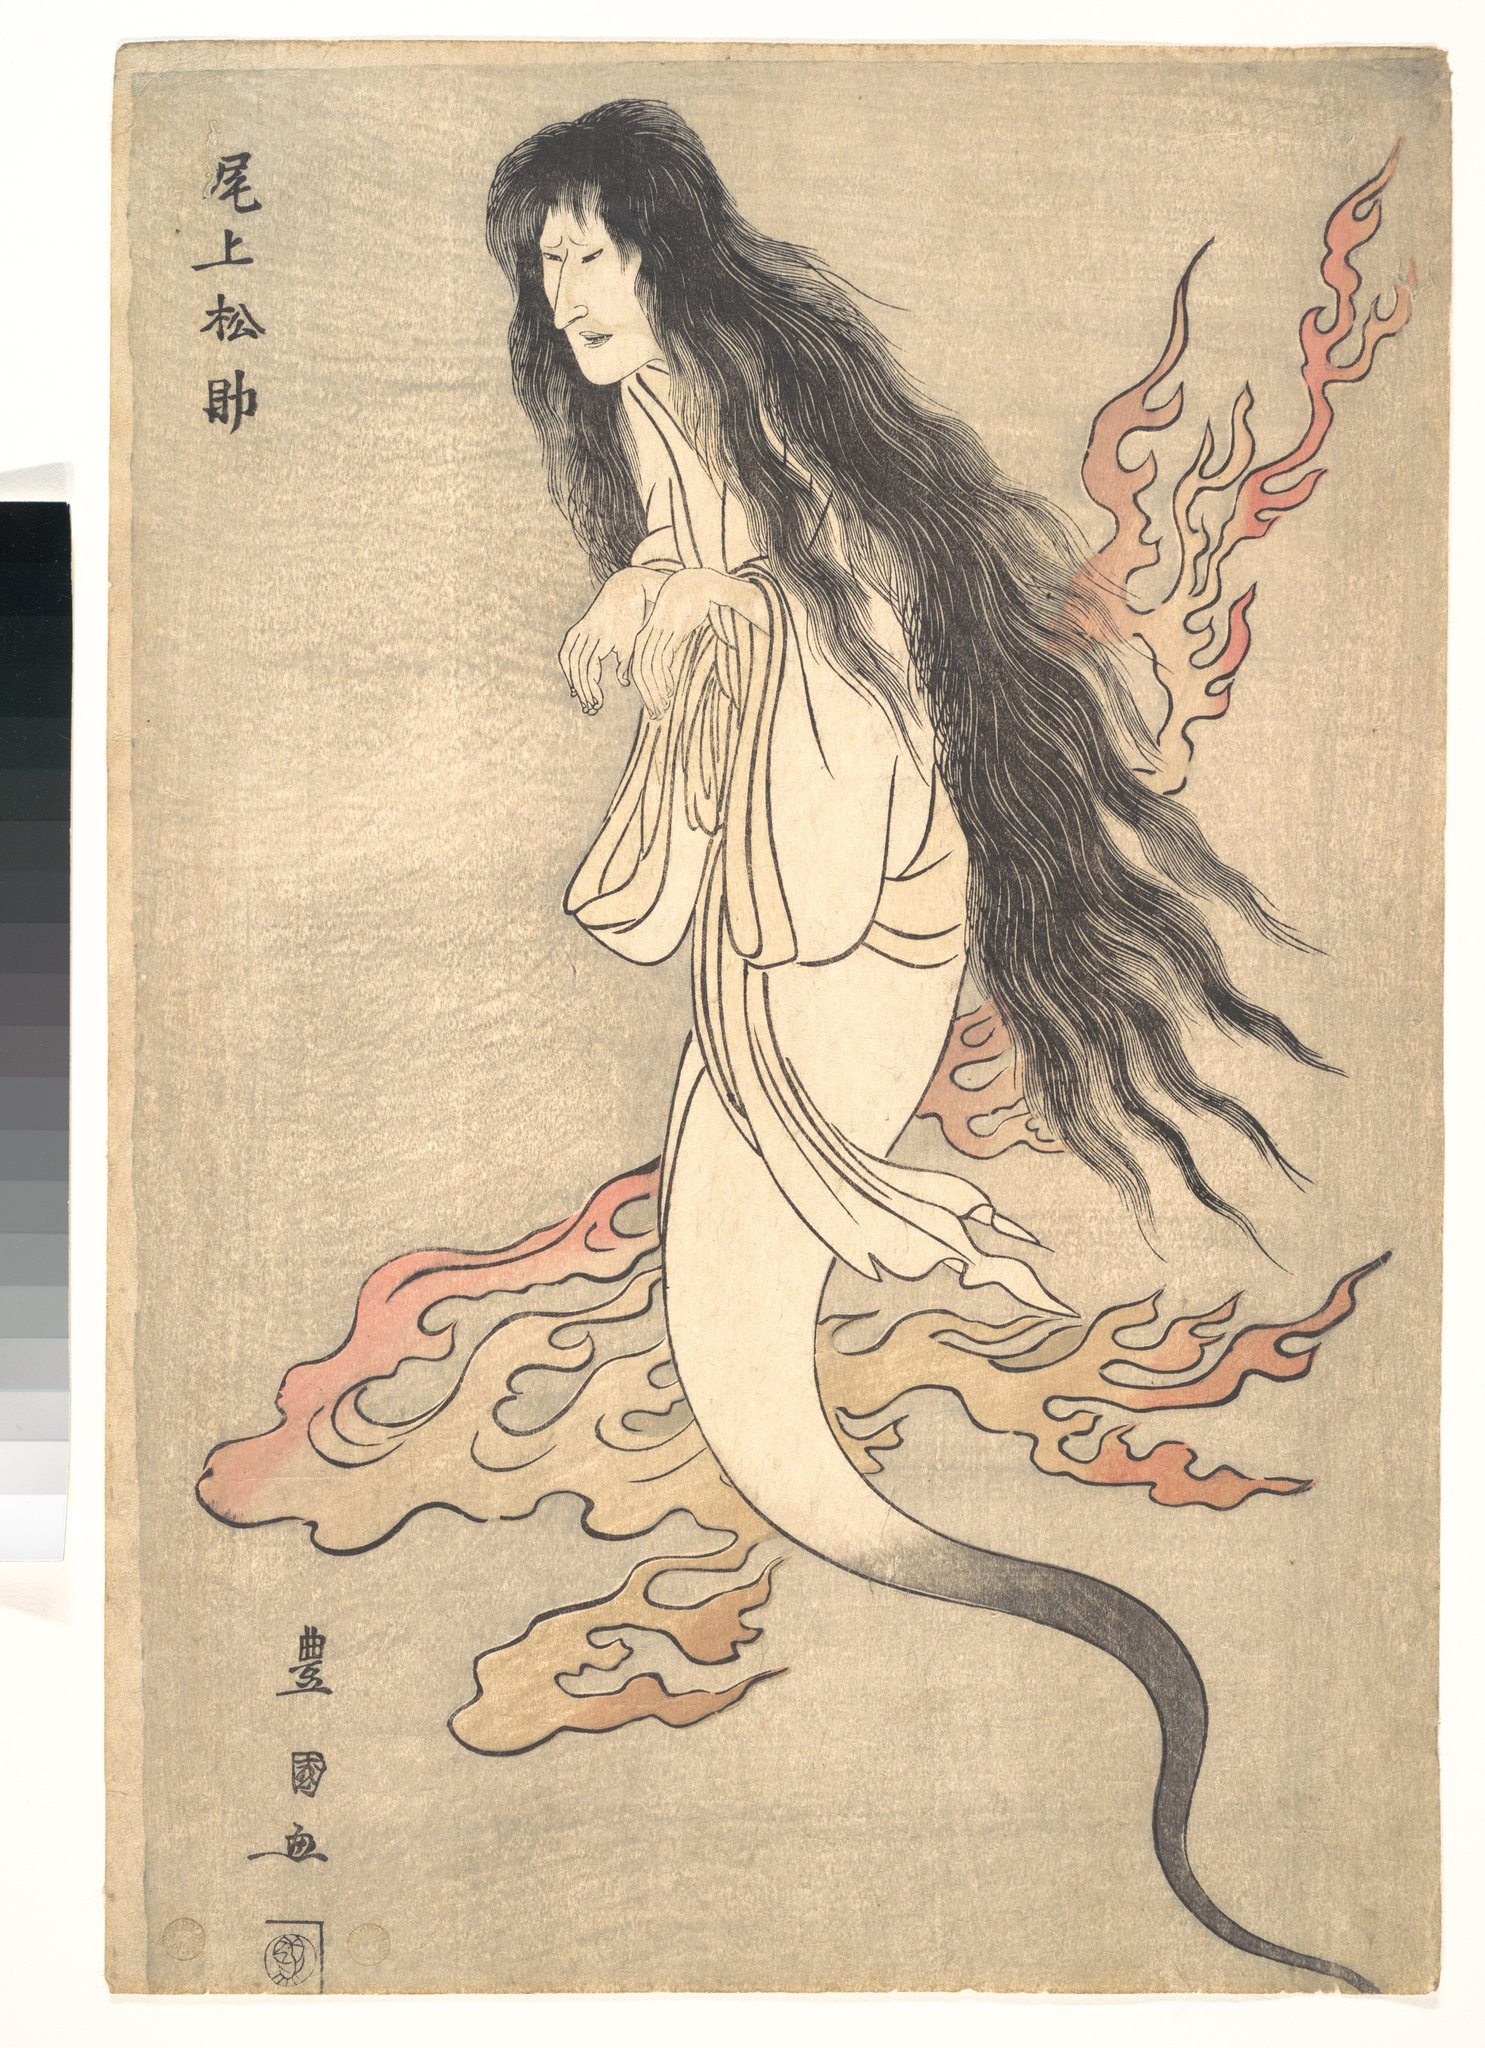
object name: print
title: Onoe Matsusuke as the Ghost of the Murdered Wife Oiwa, in "A Tale of Horror from the Yotsuya Station on the Tokaido Road"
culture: japanese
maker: utagawa toyokuni i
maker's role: artist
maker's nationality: japanese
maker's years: 1769-1825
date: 1812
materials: ink, paper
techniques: woodblock print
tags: hair,actors